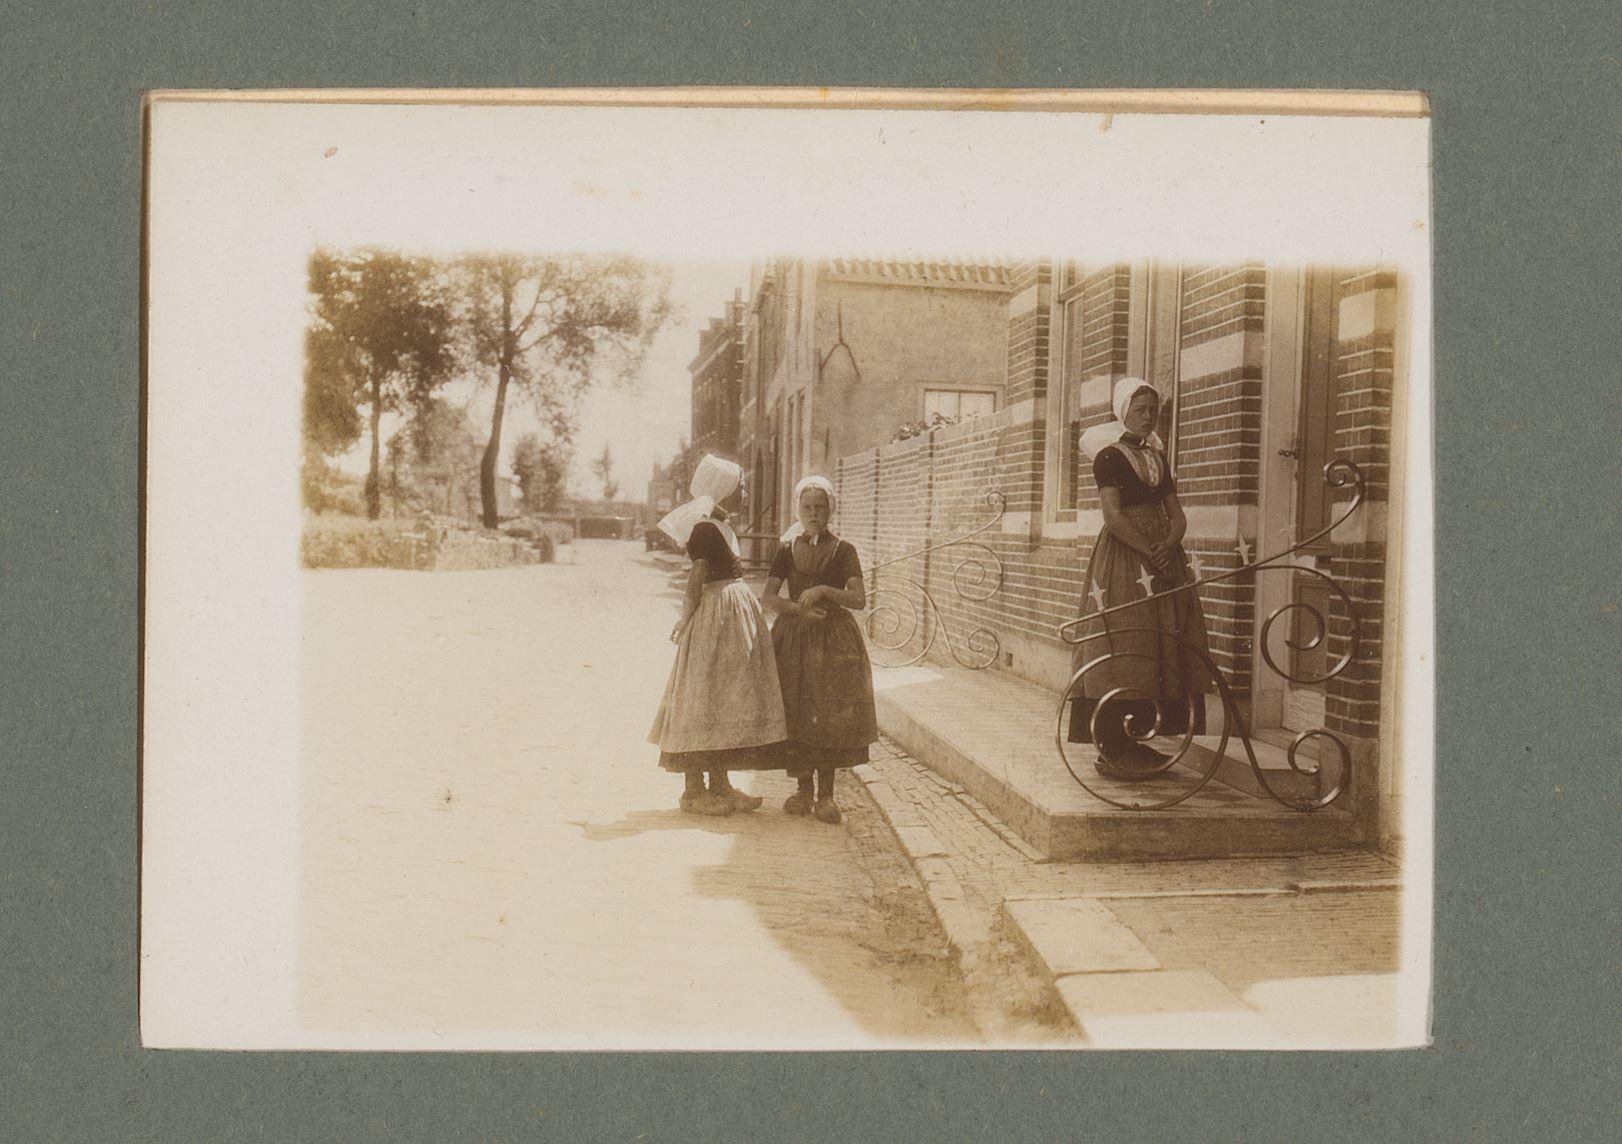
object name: photograph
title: Drie meisjes in klederdracht, staande voor een huis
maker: george hidderley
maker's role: fotograaf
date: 1920-1940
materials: photographic support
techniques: gelatin silver print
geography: netherlands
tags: girl (child between toddler and youth) (+ three persons), historical persons, folk costume, regional costume, street